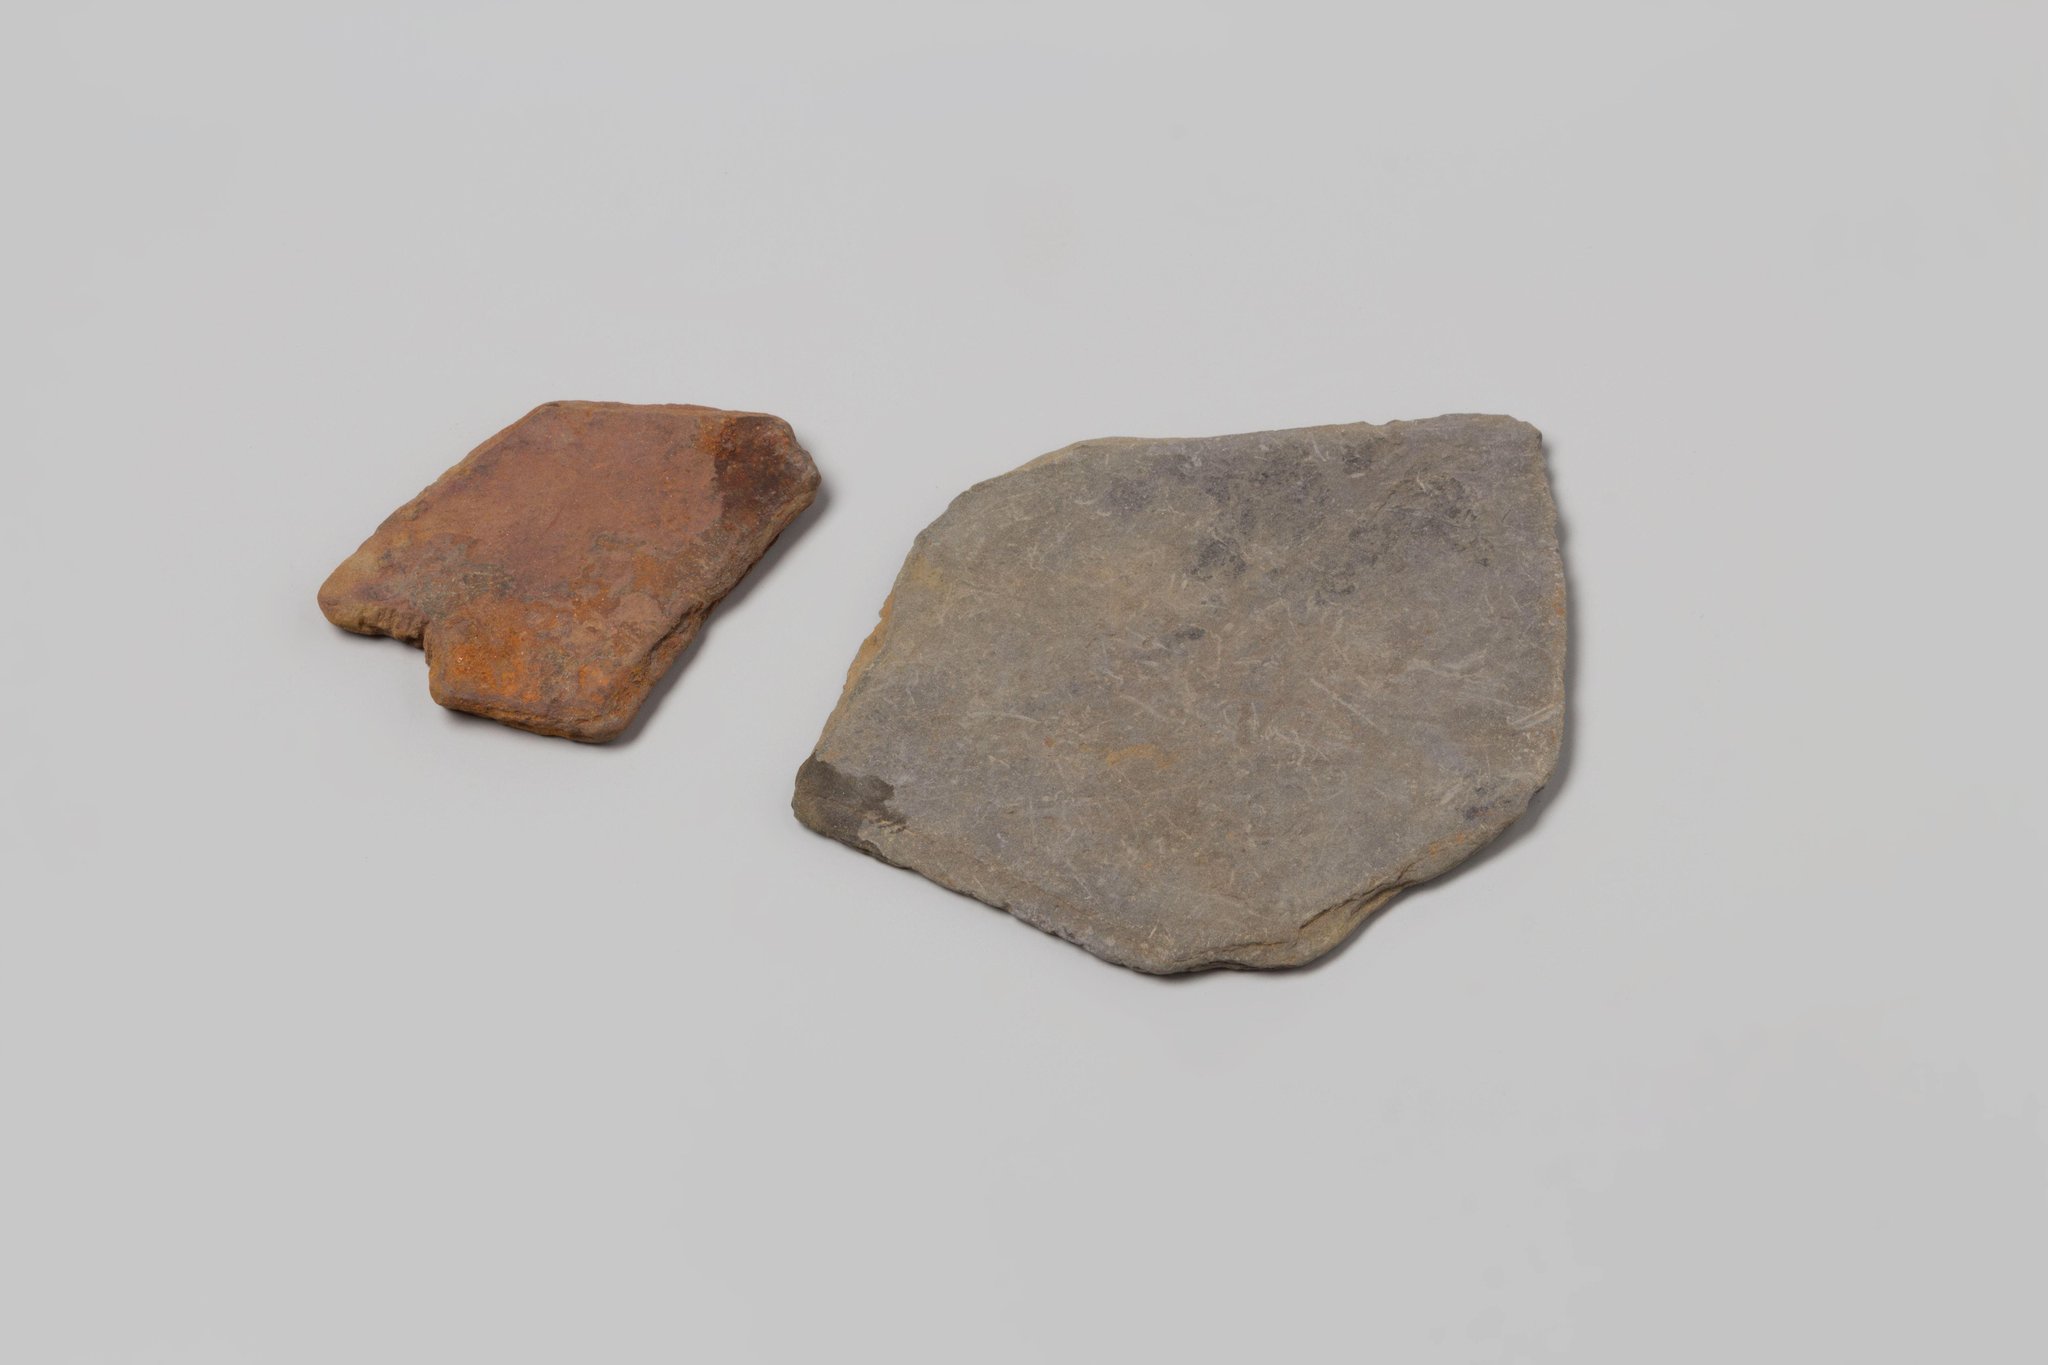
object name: scheepswrakvondst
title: Fragmenten leisteen uit het wrak van de Oost-Indiëvaarder Hollandia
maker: Anonymous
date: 1700-1743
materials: stone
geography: netherlands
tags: verenigde oostindische compagnie, hollandia (schip), annet